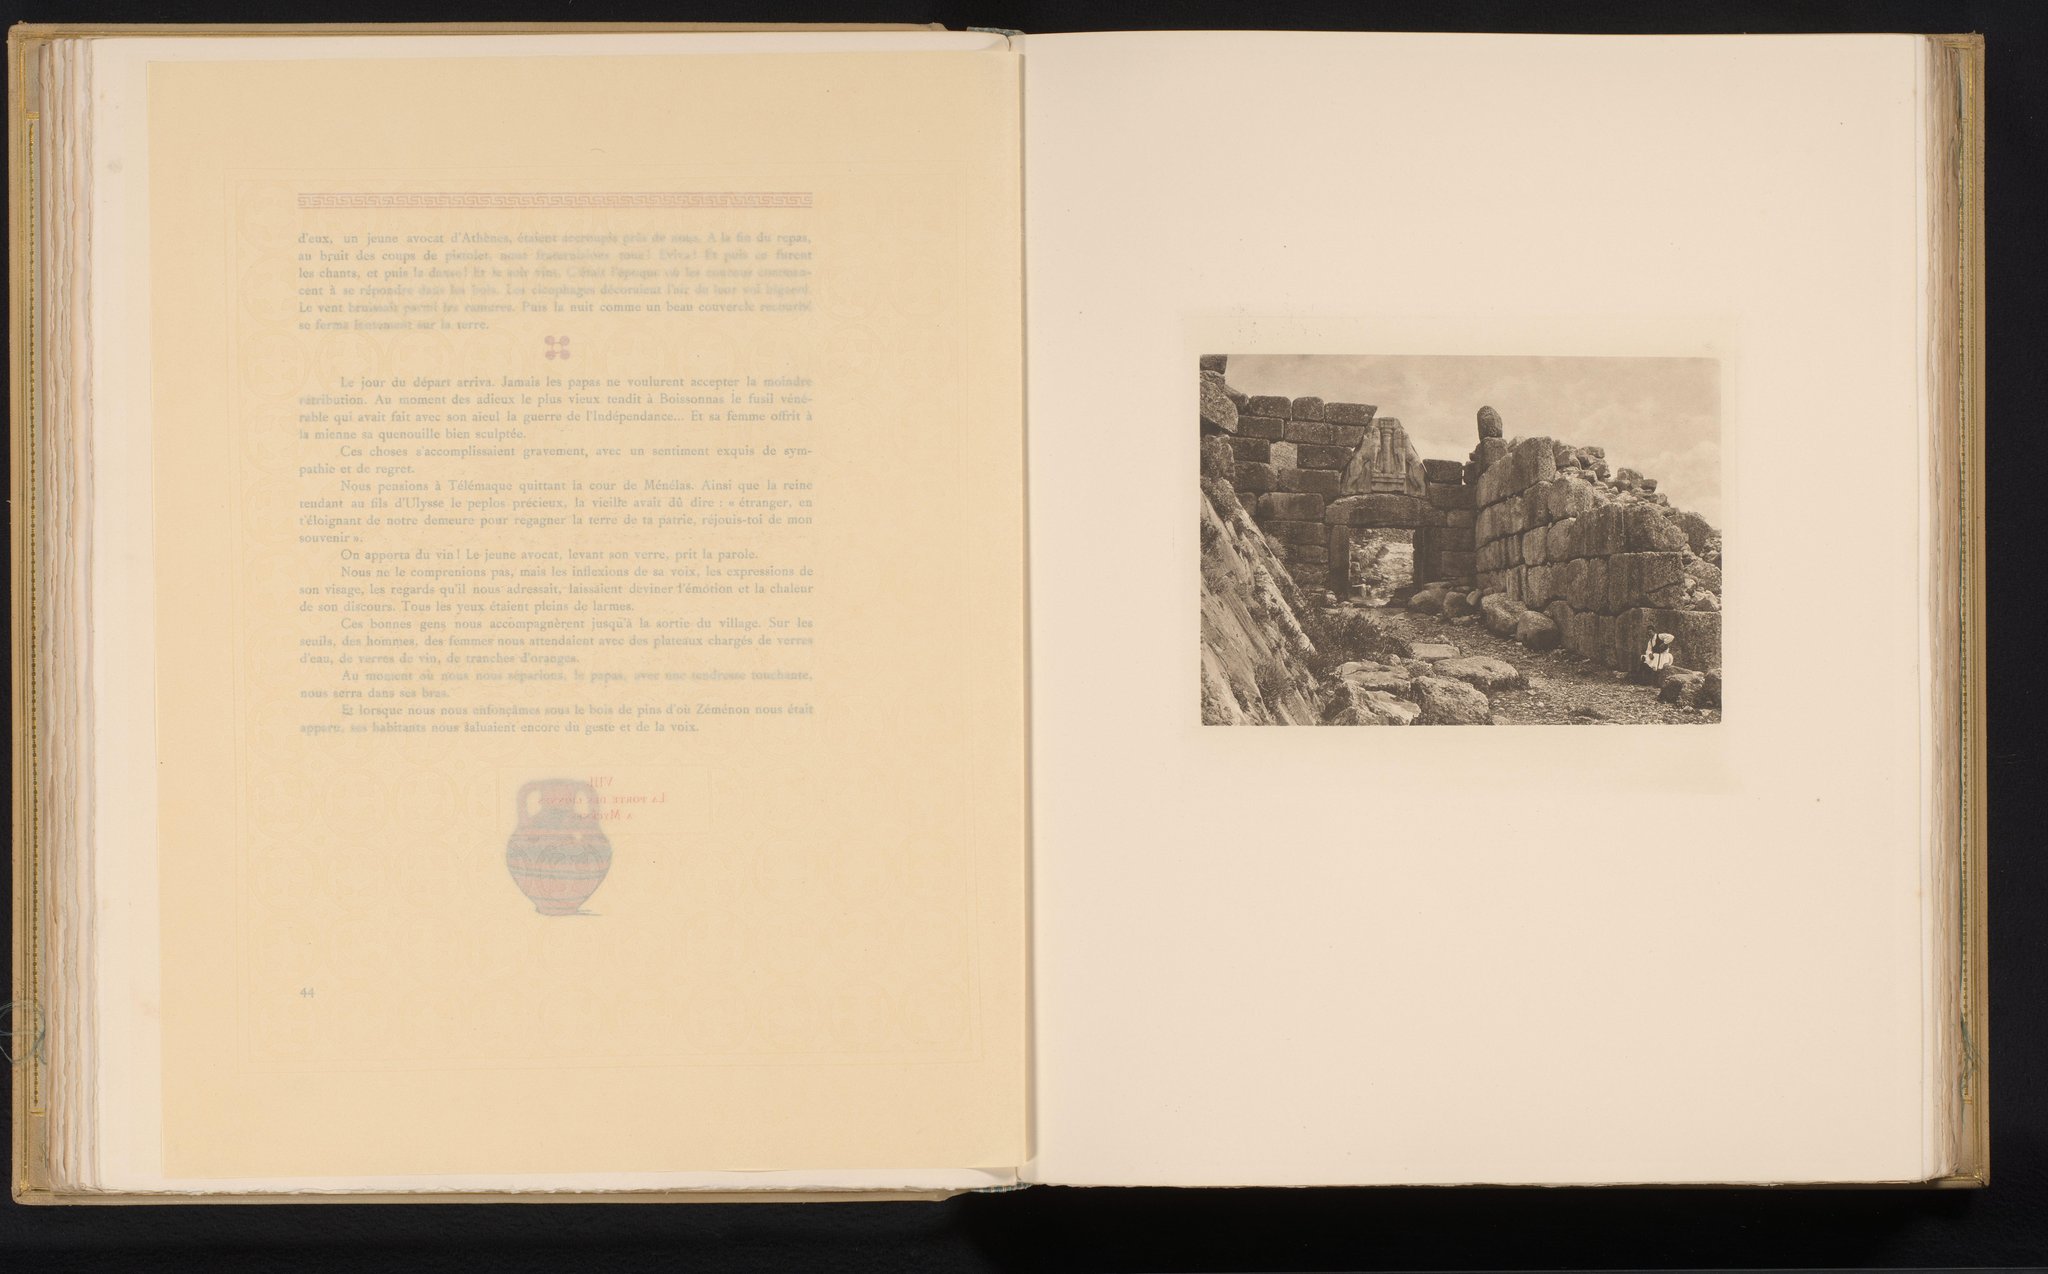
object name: page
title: La Porte des Lionnes a Mycènes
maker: frédéric boissonnas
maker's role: fotograaf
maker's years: 1858-1946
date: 1905-1910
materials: paper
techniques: photoaquatint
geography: mycene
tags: gate ~ fortified city